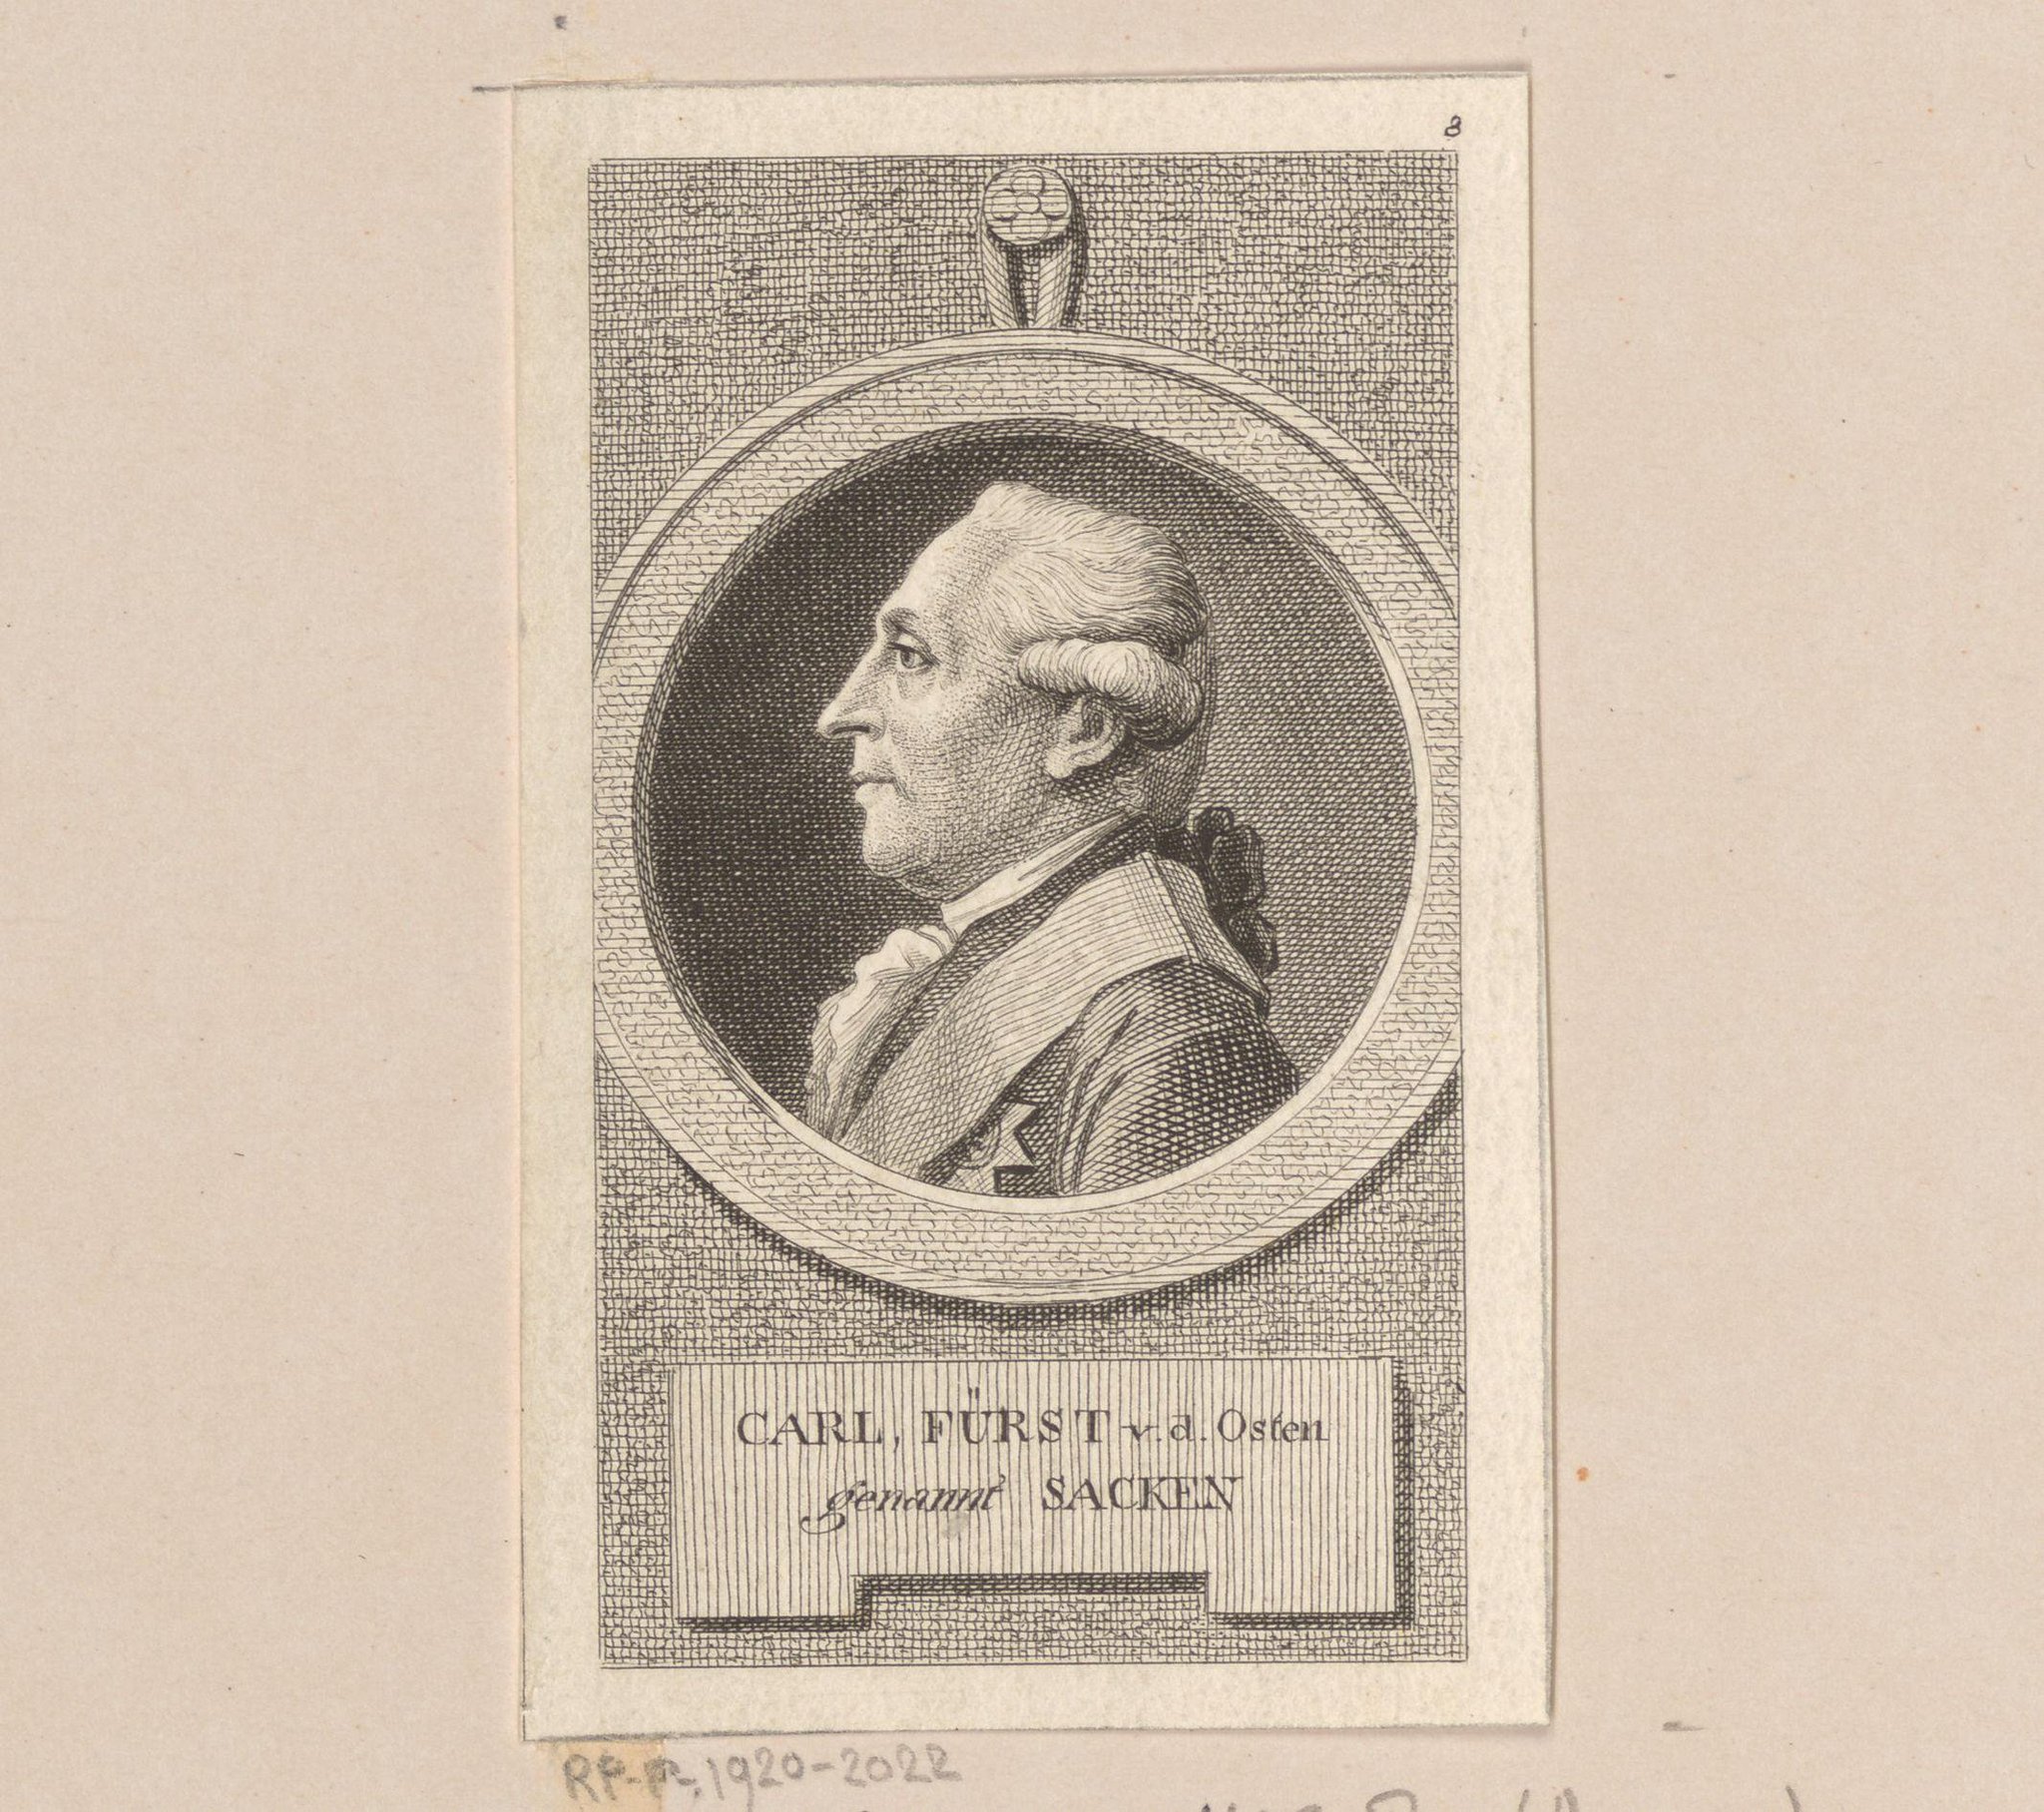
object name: print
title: Portret van Carl von der Osten-Sacken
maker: Anonymous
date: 1745-1849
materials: paper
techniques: engraving, etching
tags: berlin, historical persons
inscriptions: collector's mark: Lugt 2228